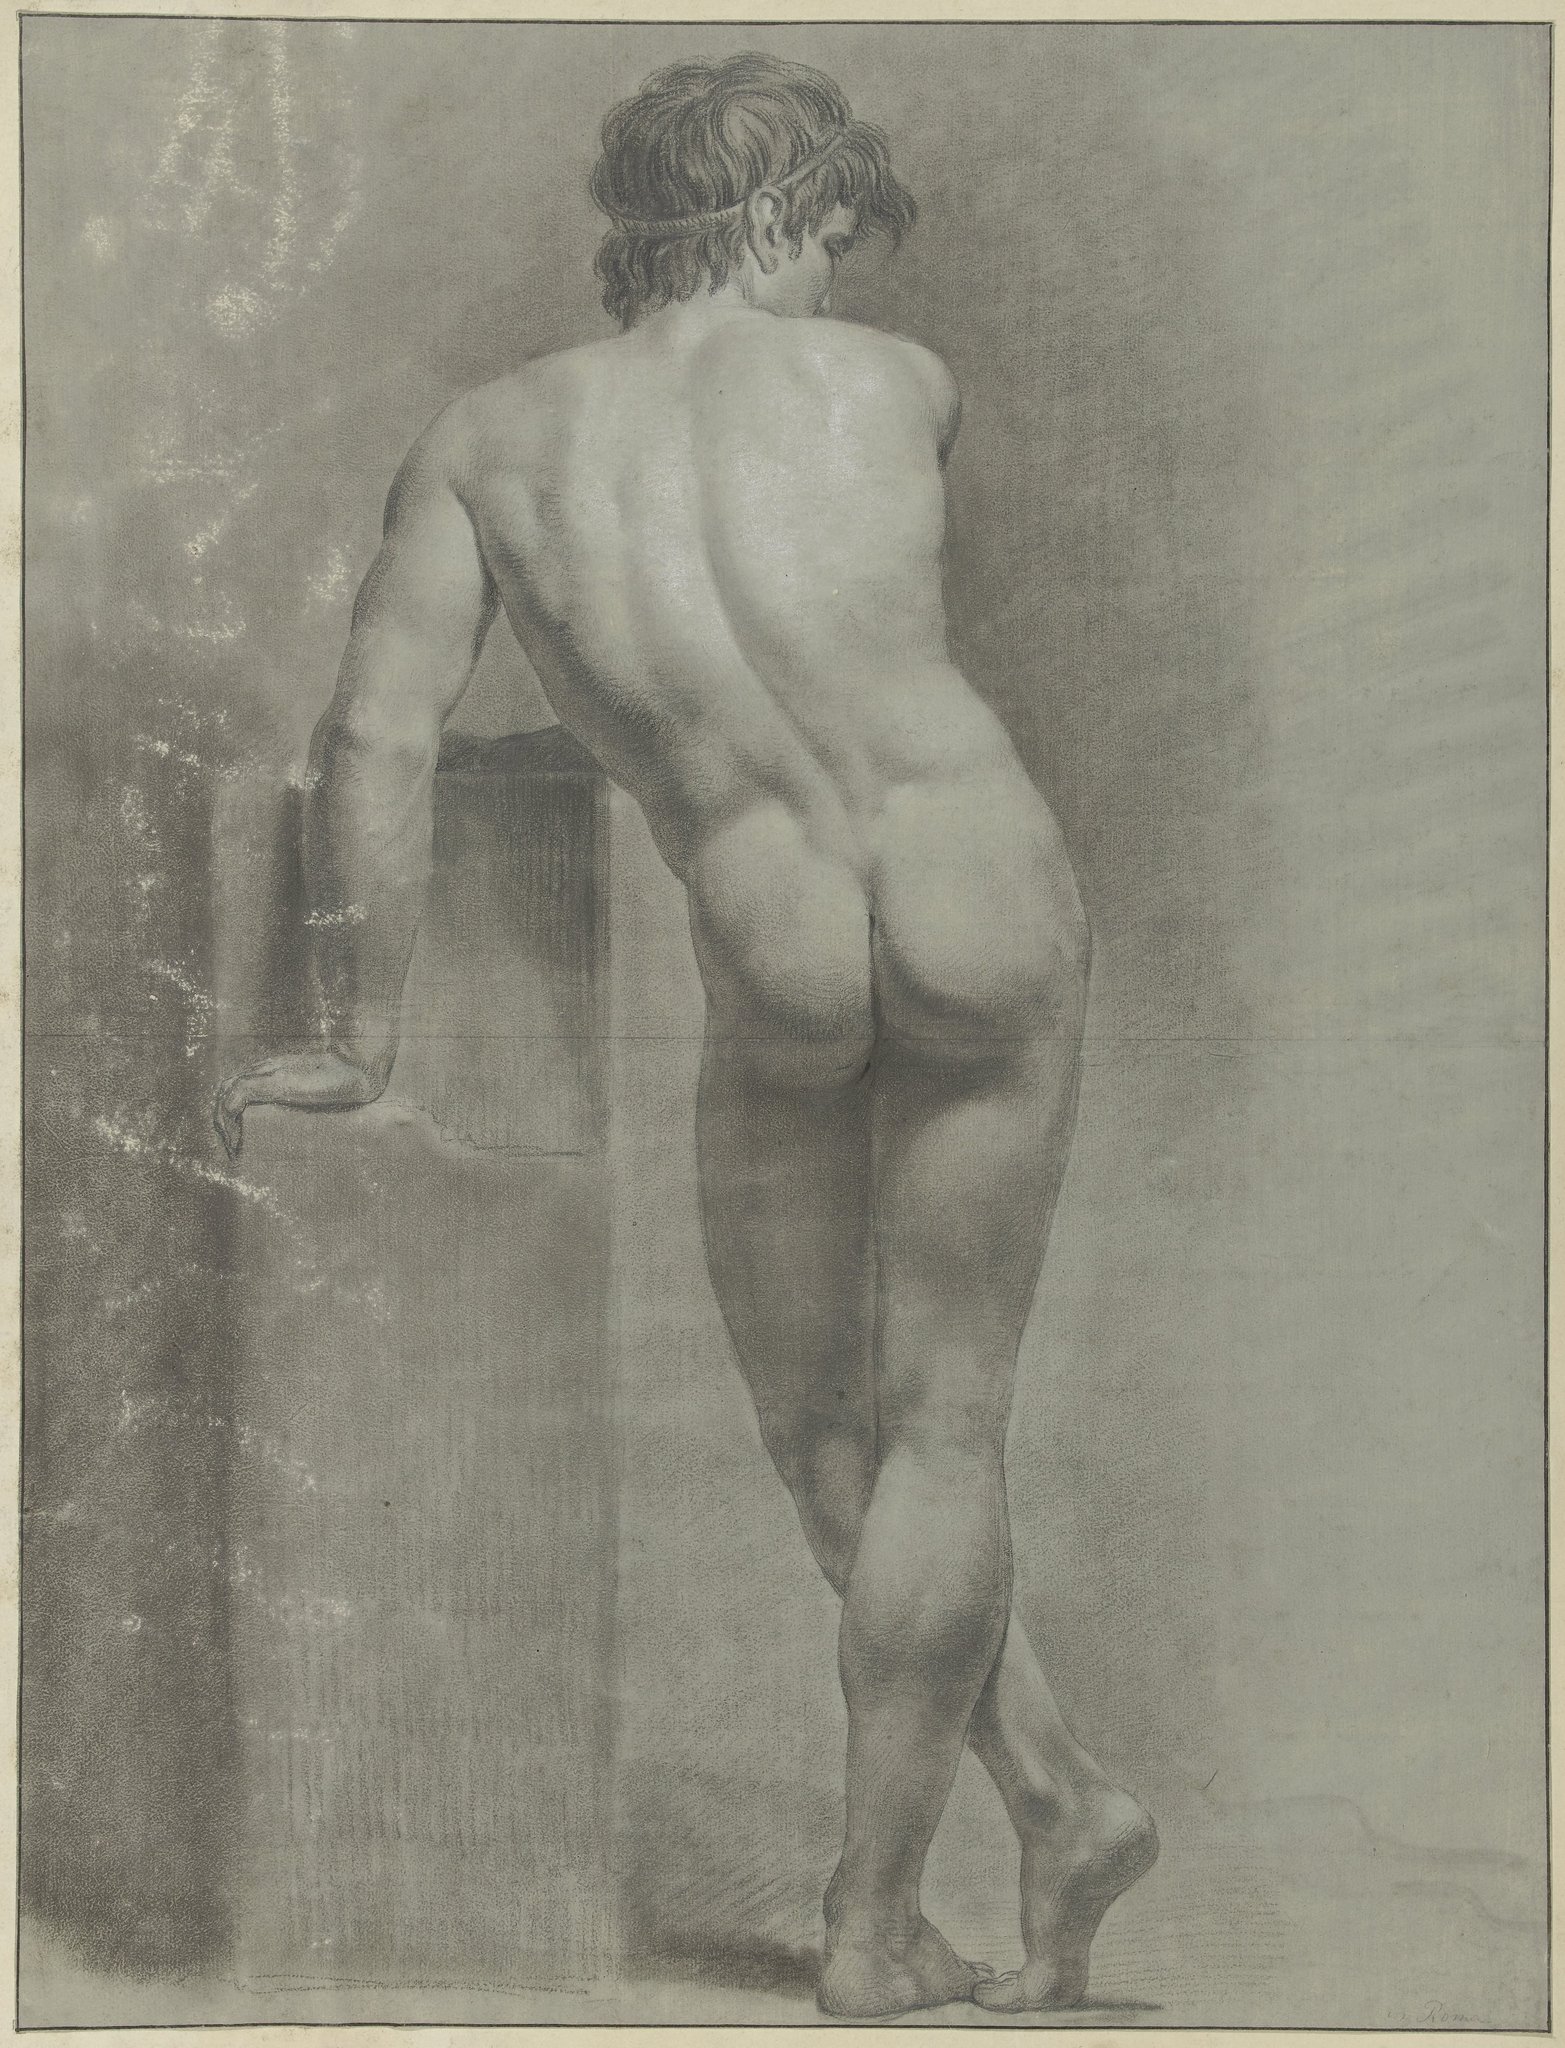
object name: drawing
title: Staand mannelijk naakt, op de rug gezien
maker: jean grandjean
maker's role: draughtsman, print maker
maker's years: 1752-1781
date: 1765-1781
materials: chalk, paper